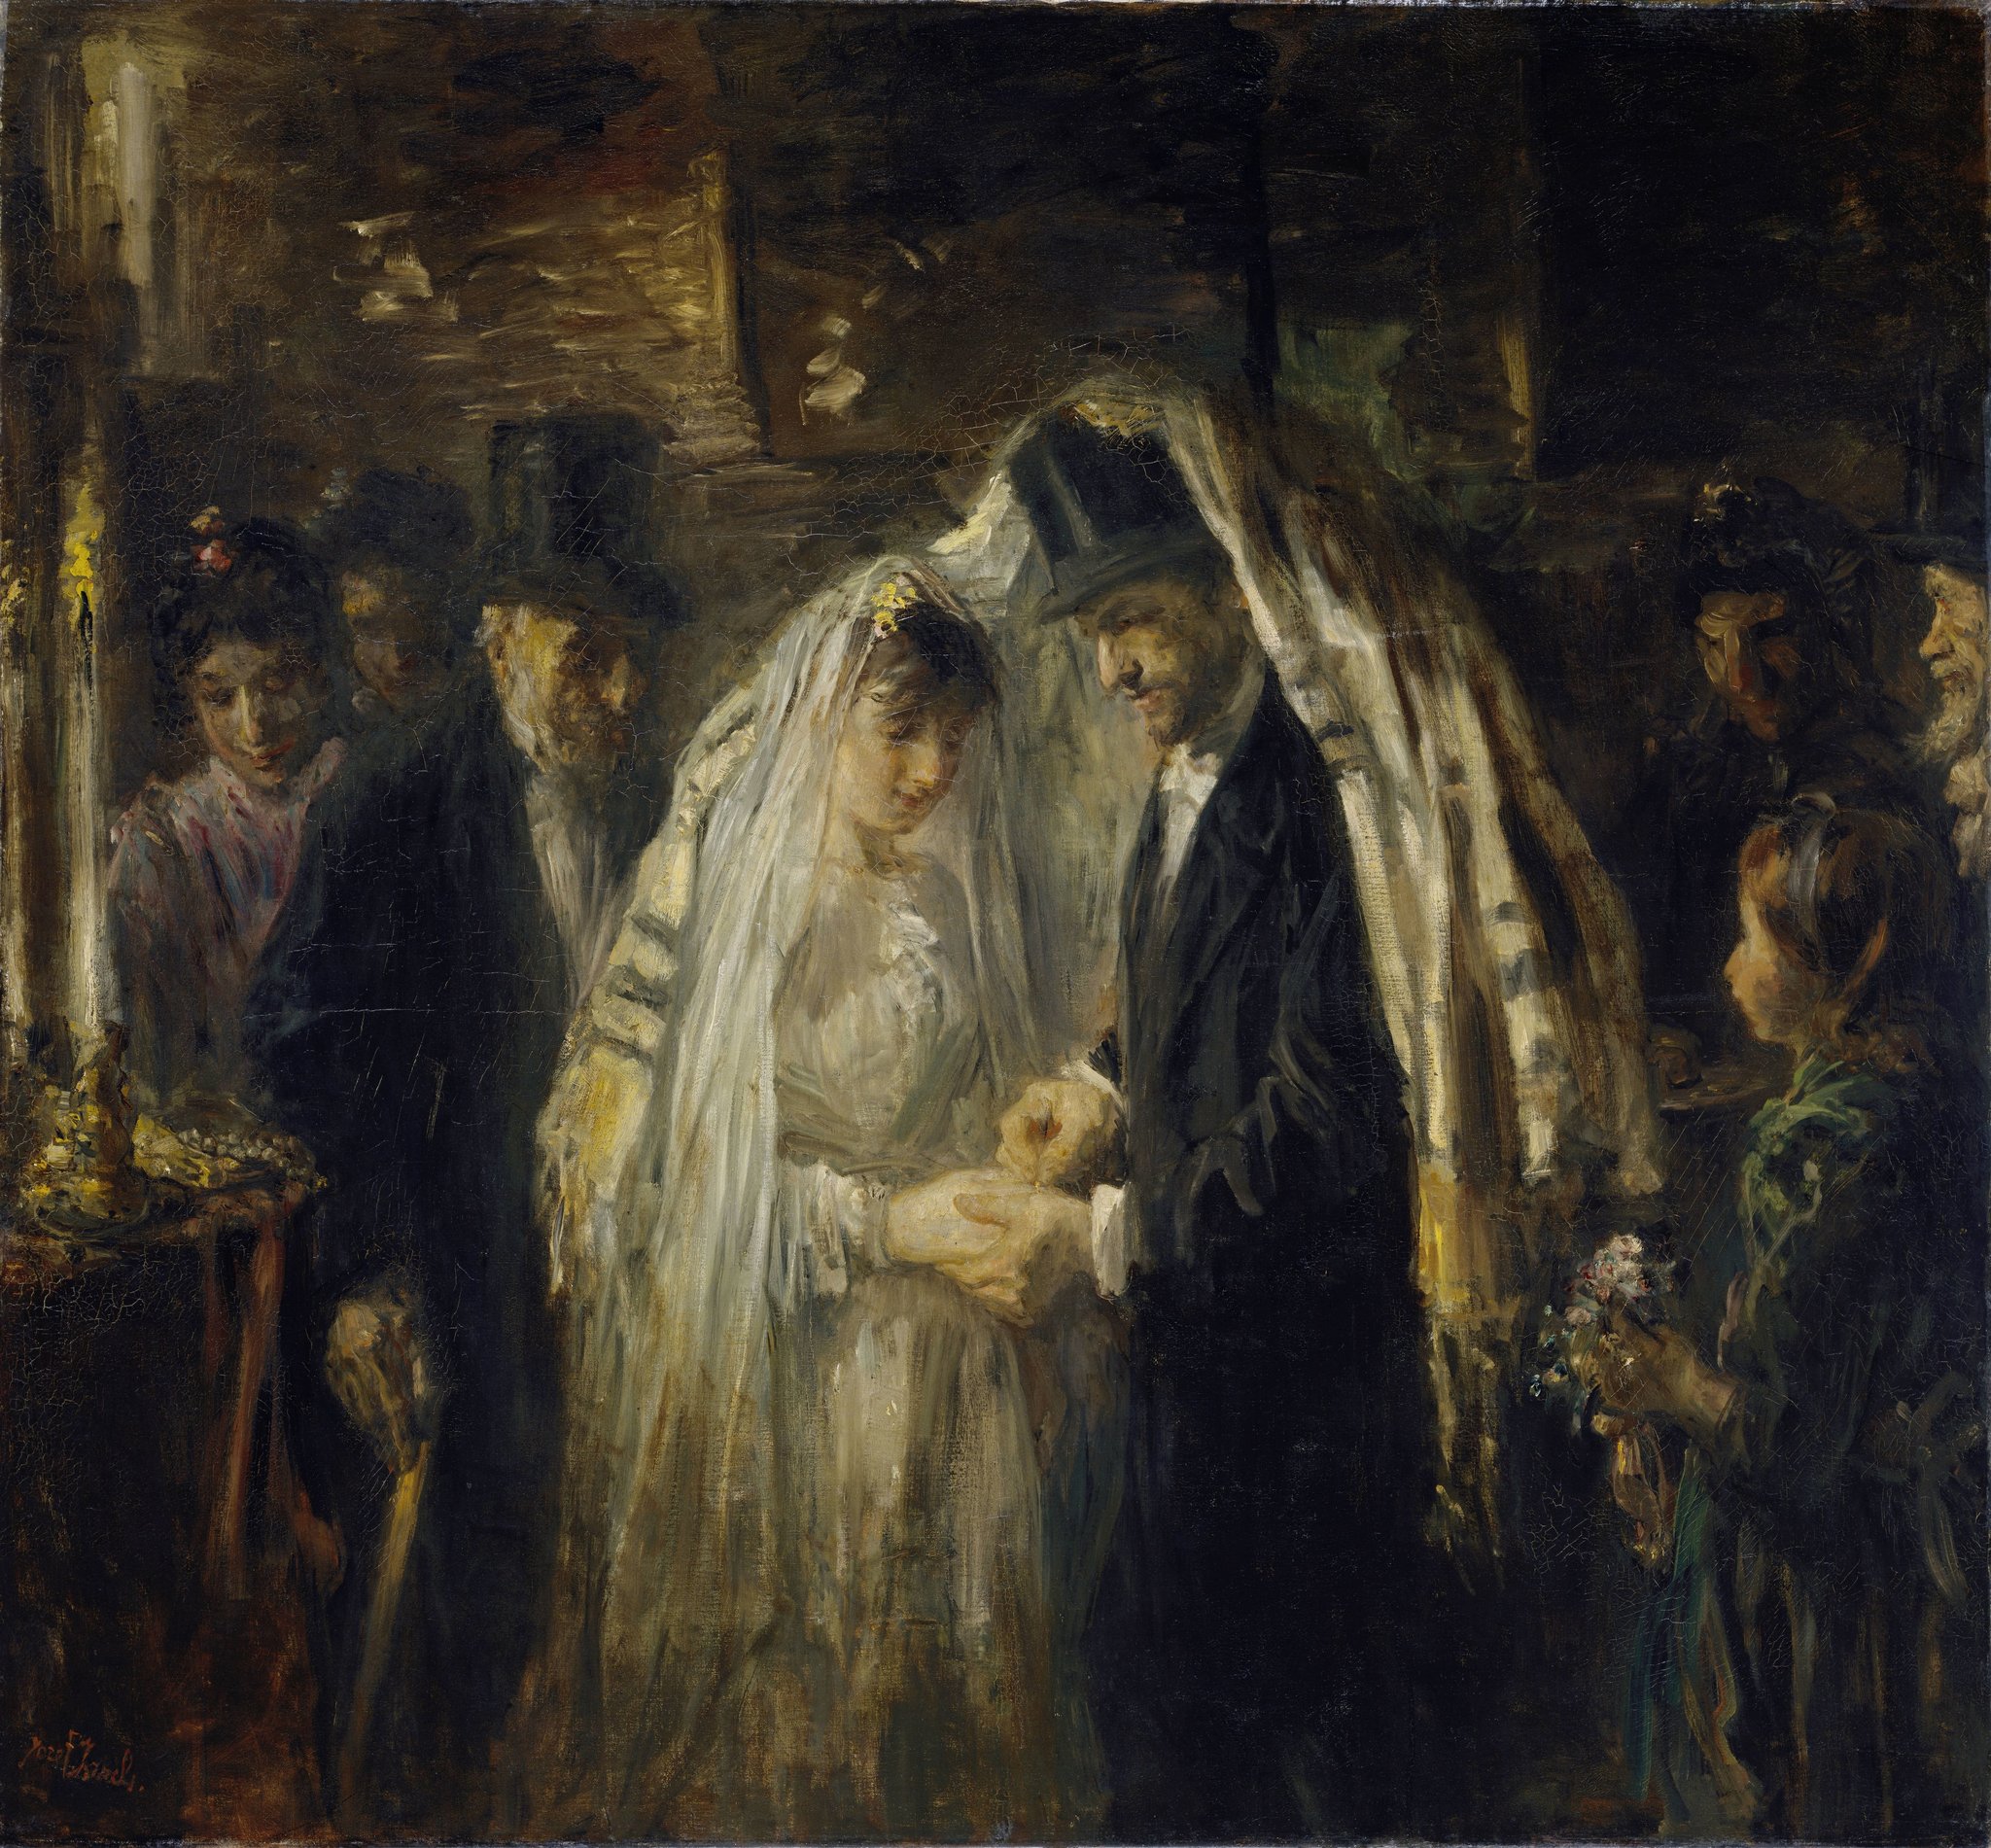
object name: painting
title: Jewish Wedding, Thought to be the Wedding of the Artist's Daughter Mathilde and G.D. Cohen Tervaert, 1903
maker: jozef israëls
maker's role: draughtsman, painter, print maker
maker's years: 1824-1911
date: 1903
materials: canvas, oil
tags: 'kiddushin', jewish wedding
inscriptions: signature: ‘Jozef Israels’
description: Een joodse bruiloft. Het bruidspaar staat onder het gebedskleed, de bruidegom schuift de ring om de vinger van zijn bruid. Links een oude man met hoge hoed bij een brandende kaars, om het paar heen staan de bruiloftsgasten.